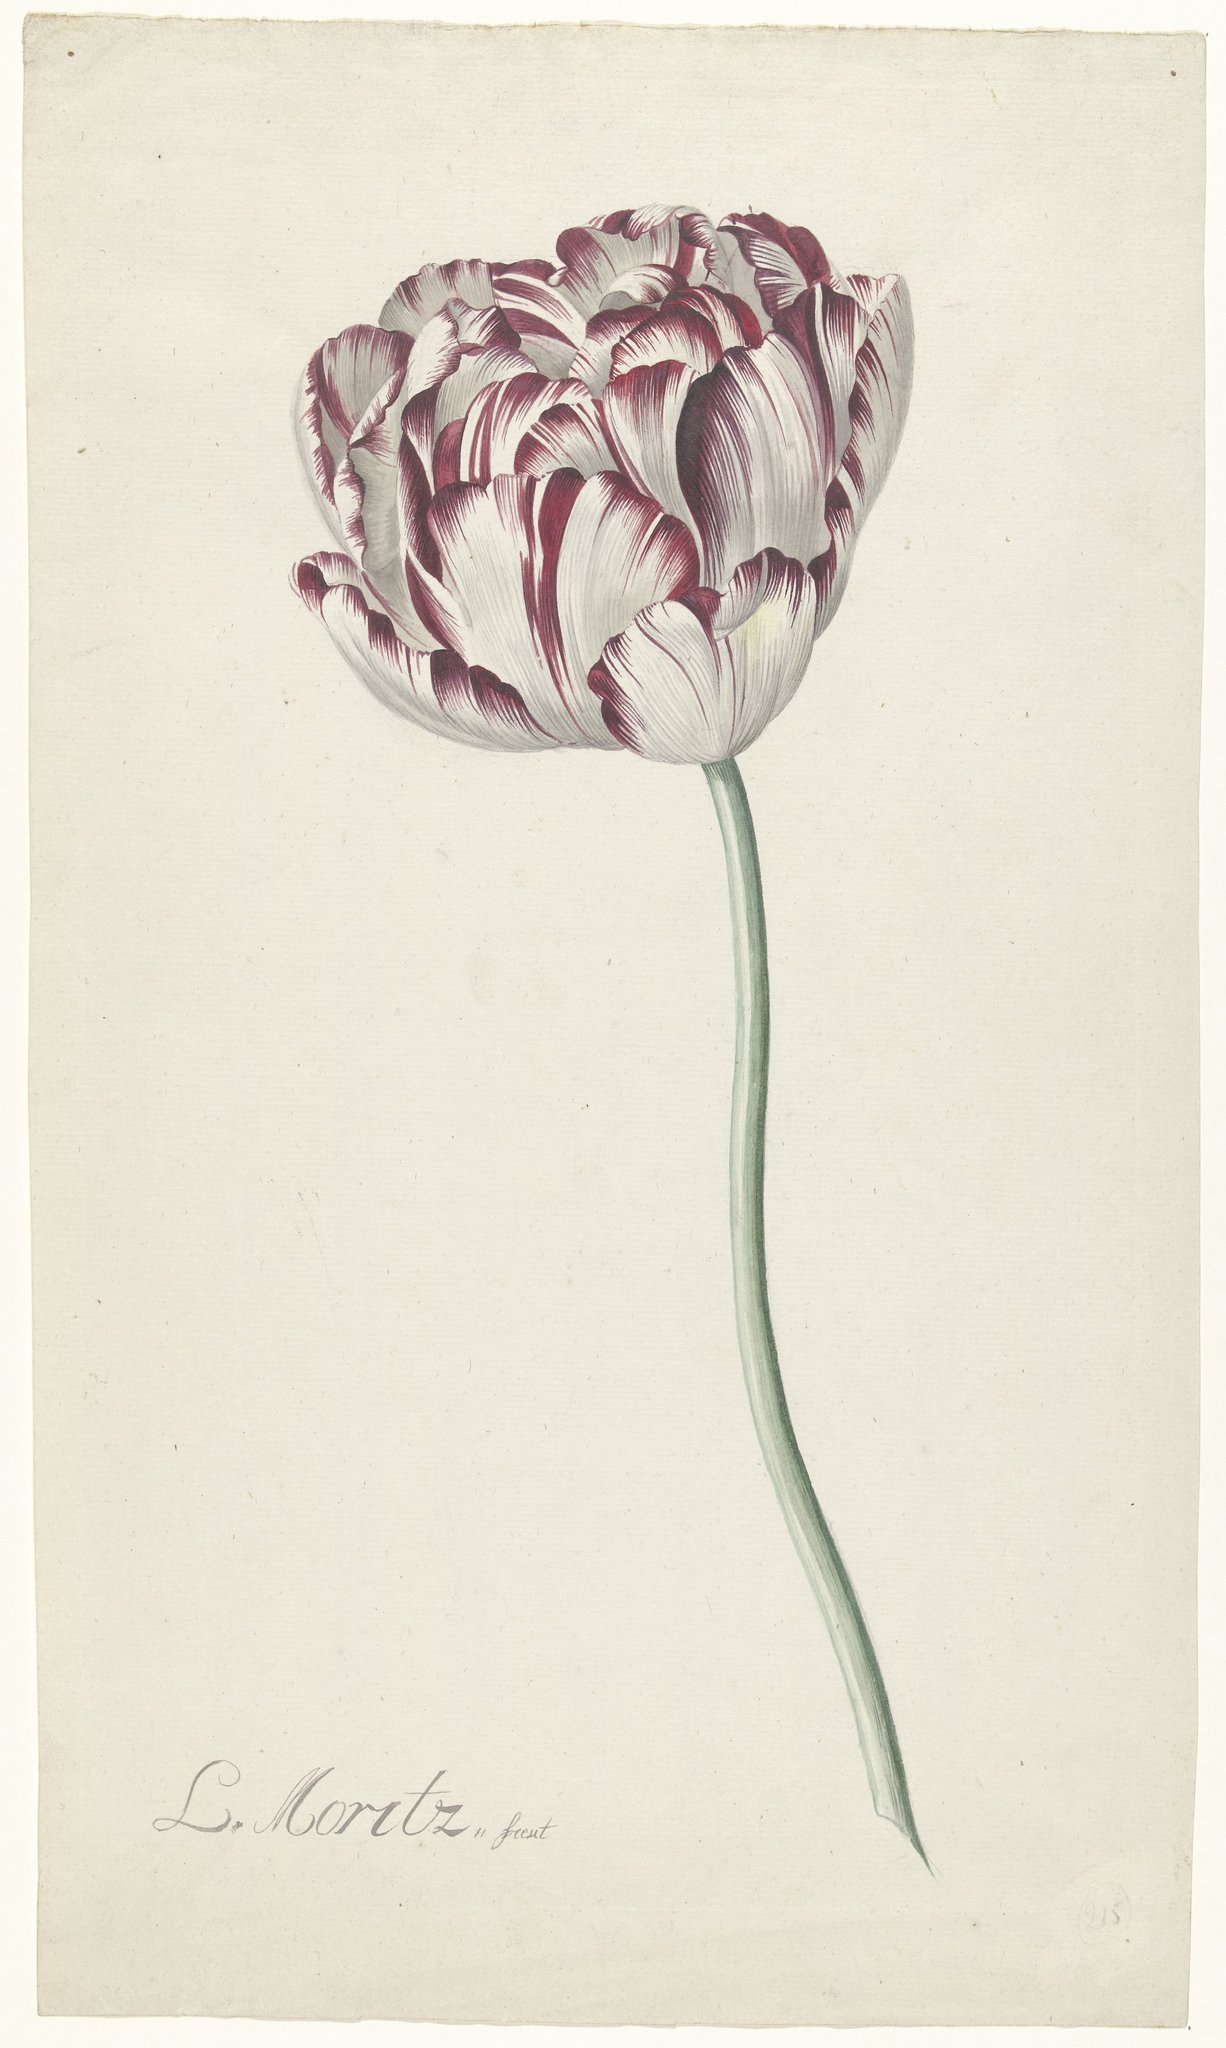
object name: watercolor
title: Tulp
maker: louis moritz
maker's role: draughtsman, painter, print maker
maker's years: 1773-1850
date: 1783-1850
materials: paper, pencil, watercolor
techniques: brush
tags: flowers: tulip